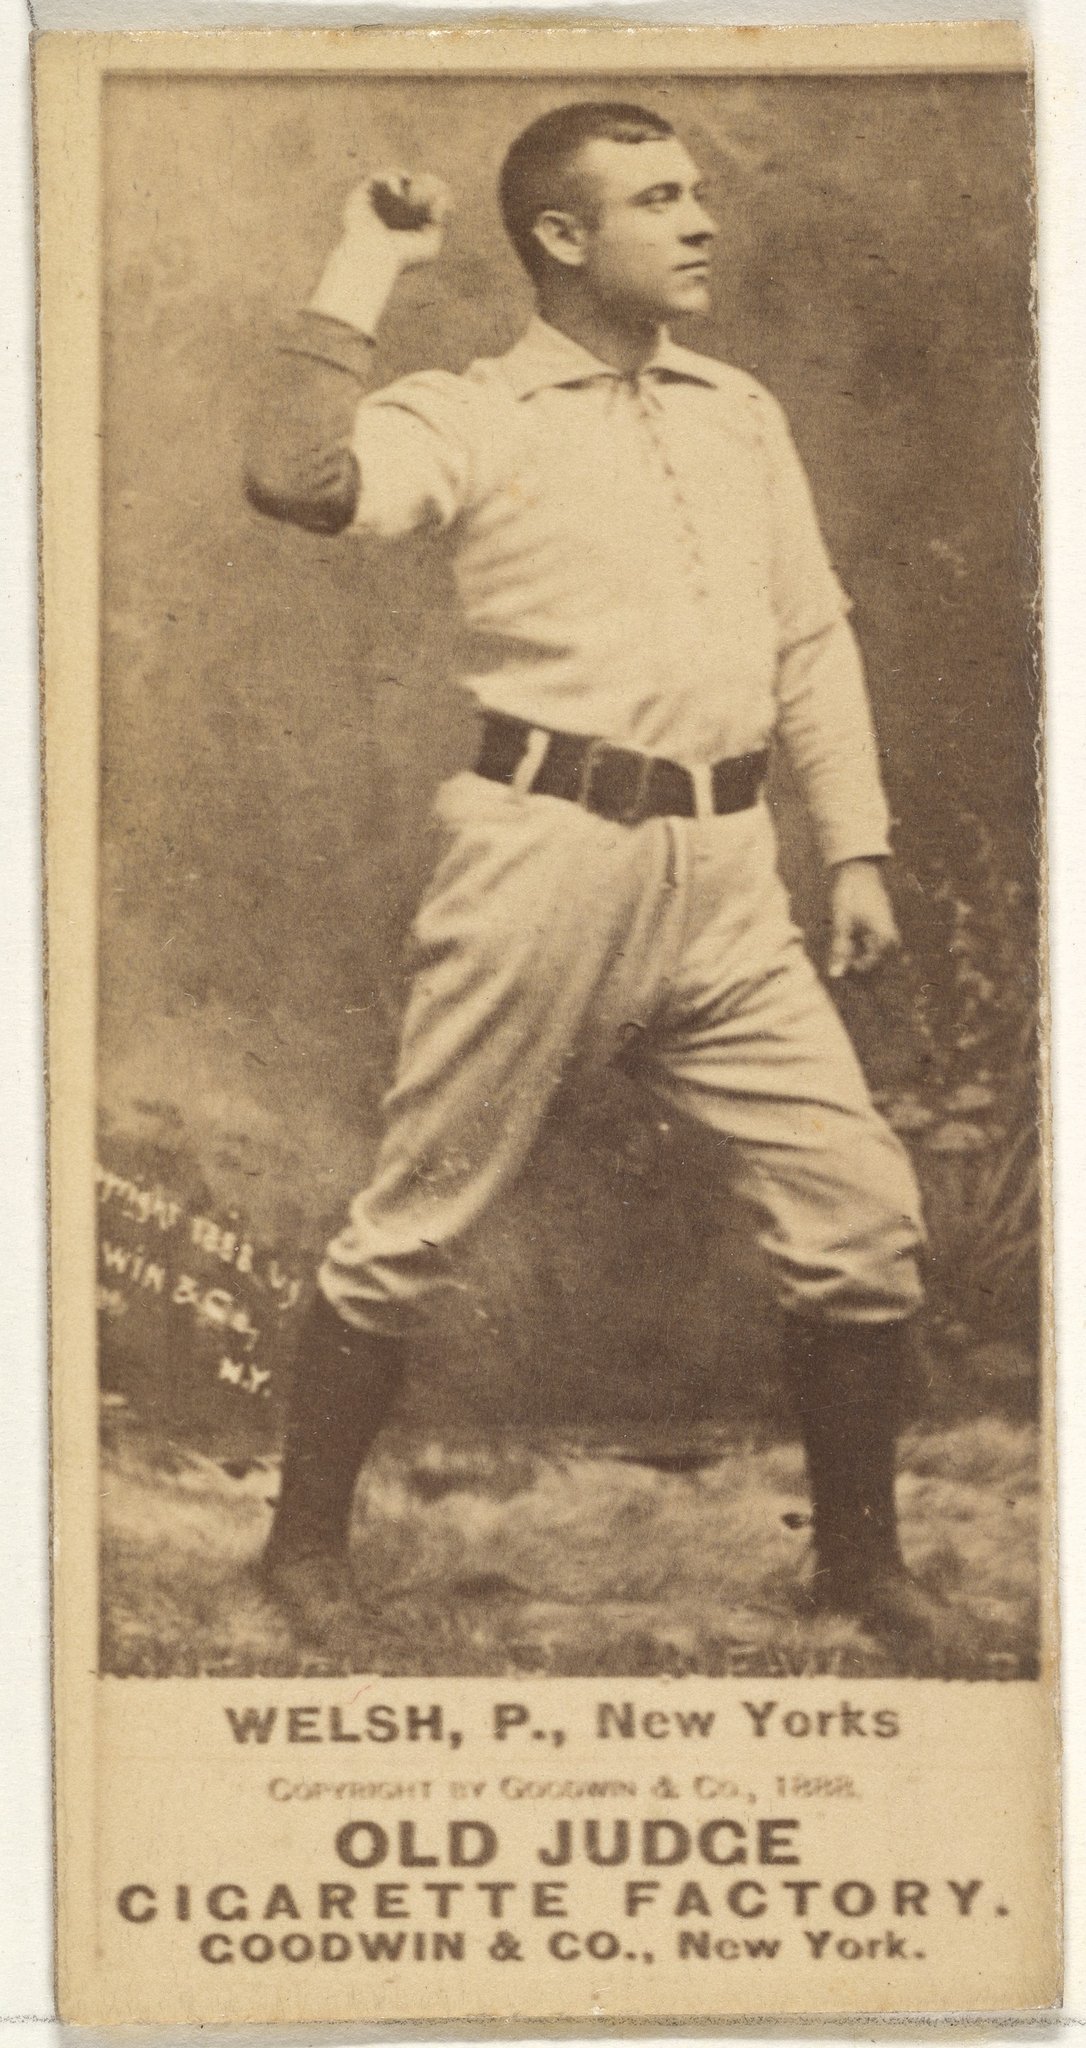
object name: baseball card, photograph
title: Michael "Mickey" Francis Welch, Pitcher, New York, from the Old Judge series (N172) for Old Judge Cigarettes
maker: goodwin & company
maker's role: publisher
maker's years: 1850-1950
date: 1888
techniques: albumen silver print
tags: men,portraits,baseball,athletes